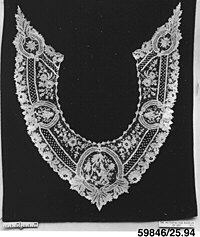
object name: collar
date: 1834-1866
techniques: lace